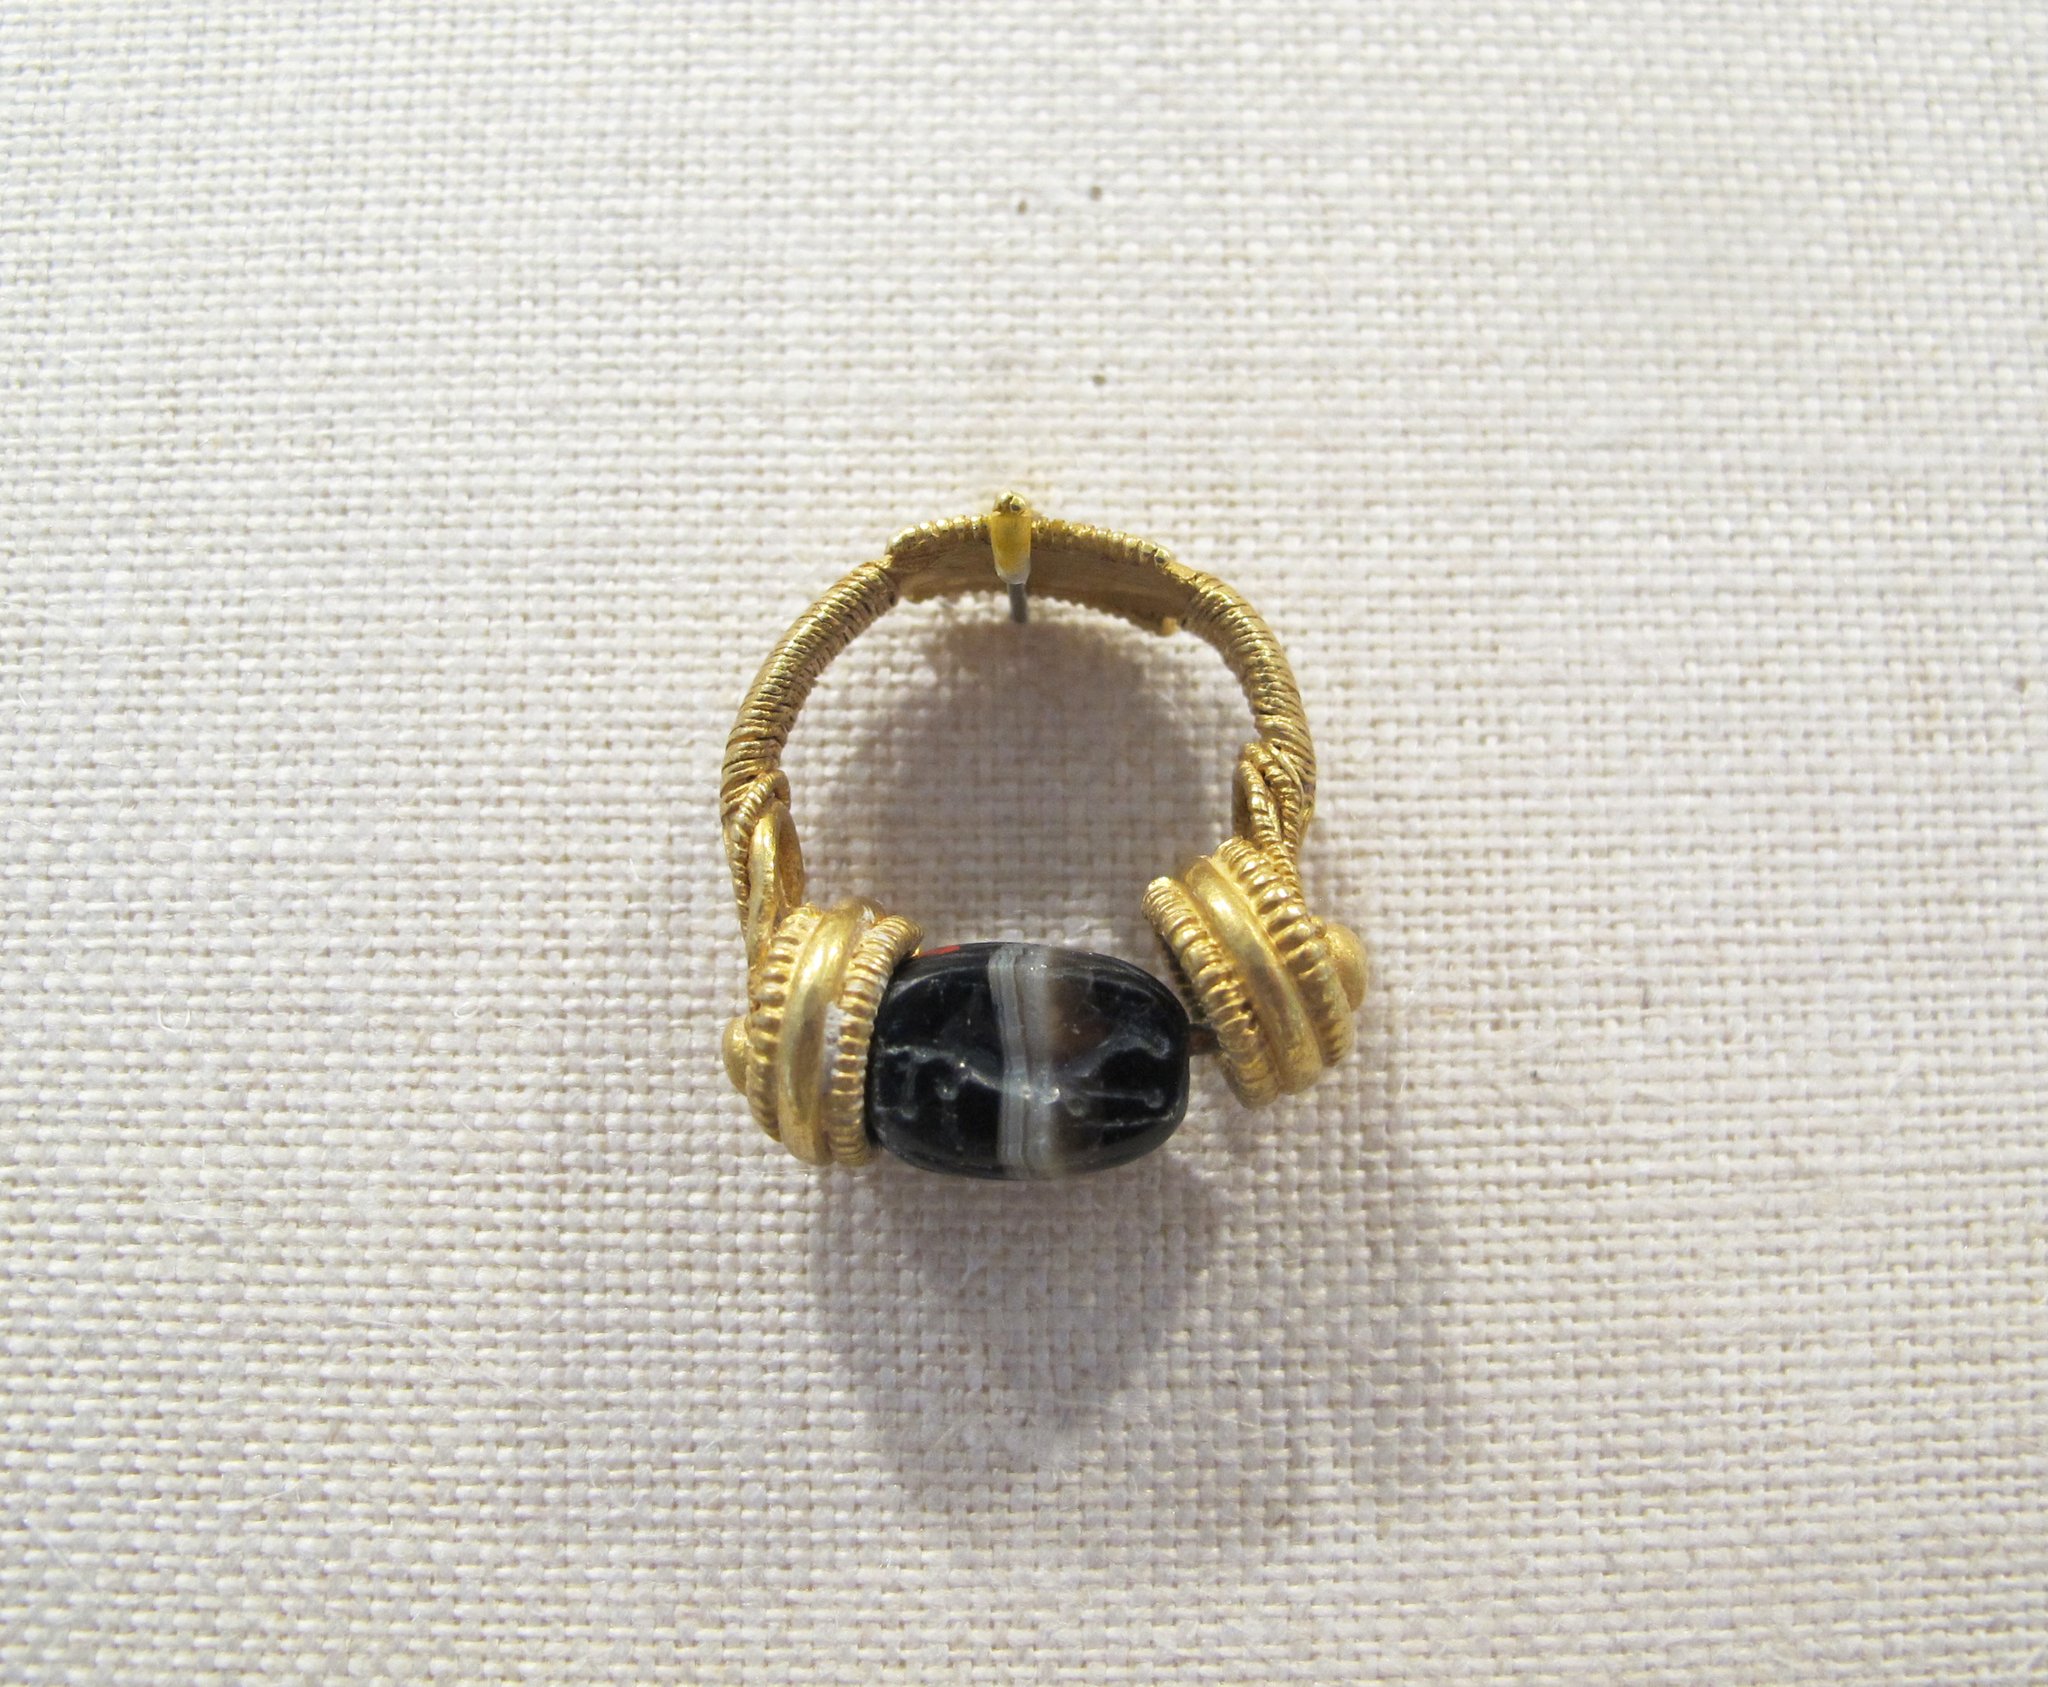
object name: ring with scarab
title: Gold swivel ring with banded agate scarab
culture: etruscan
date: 400-301 BCE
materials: stone, gold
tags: horses,scarabs